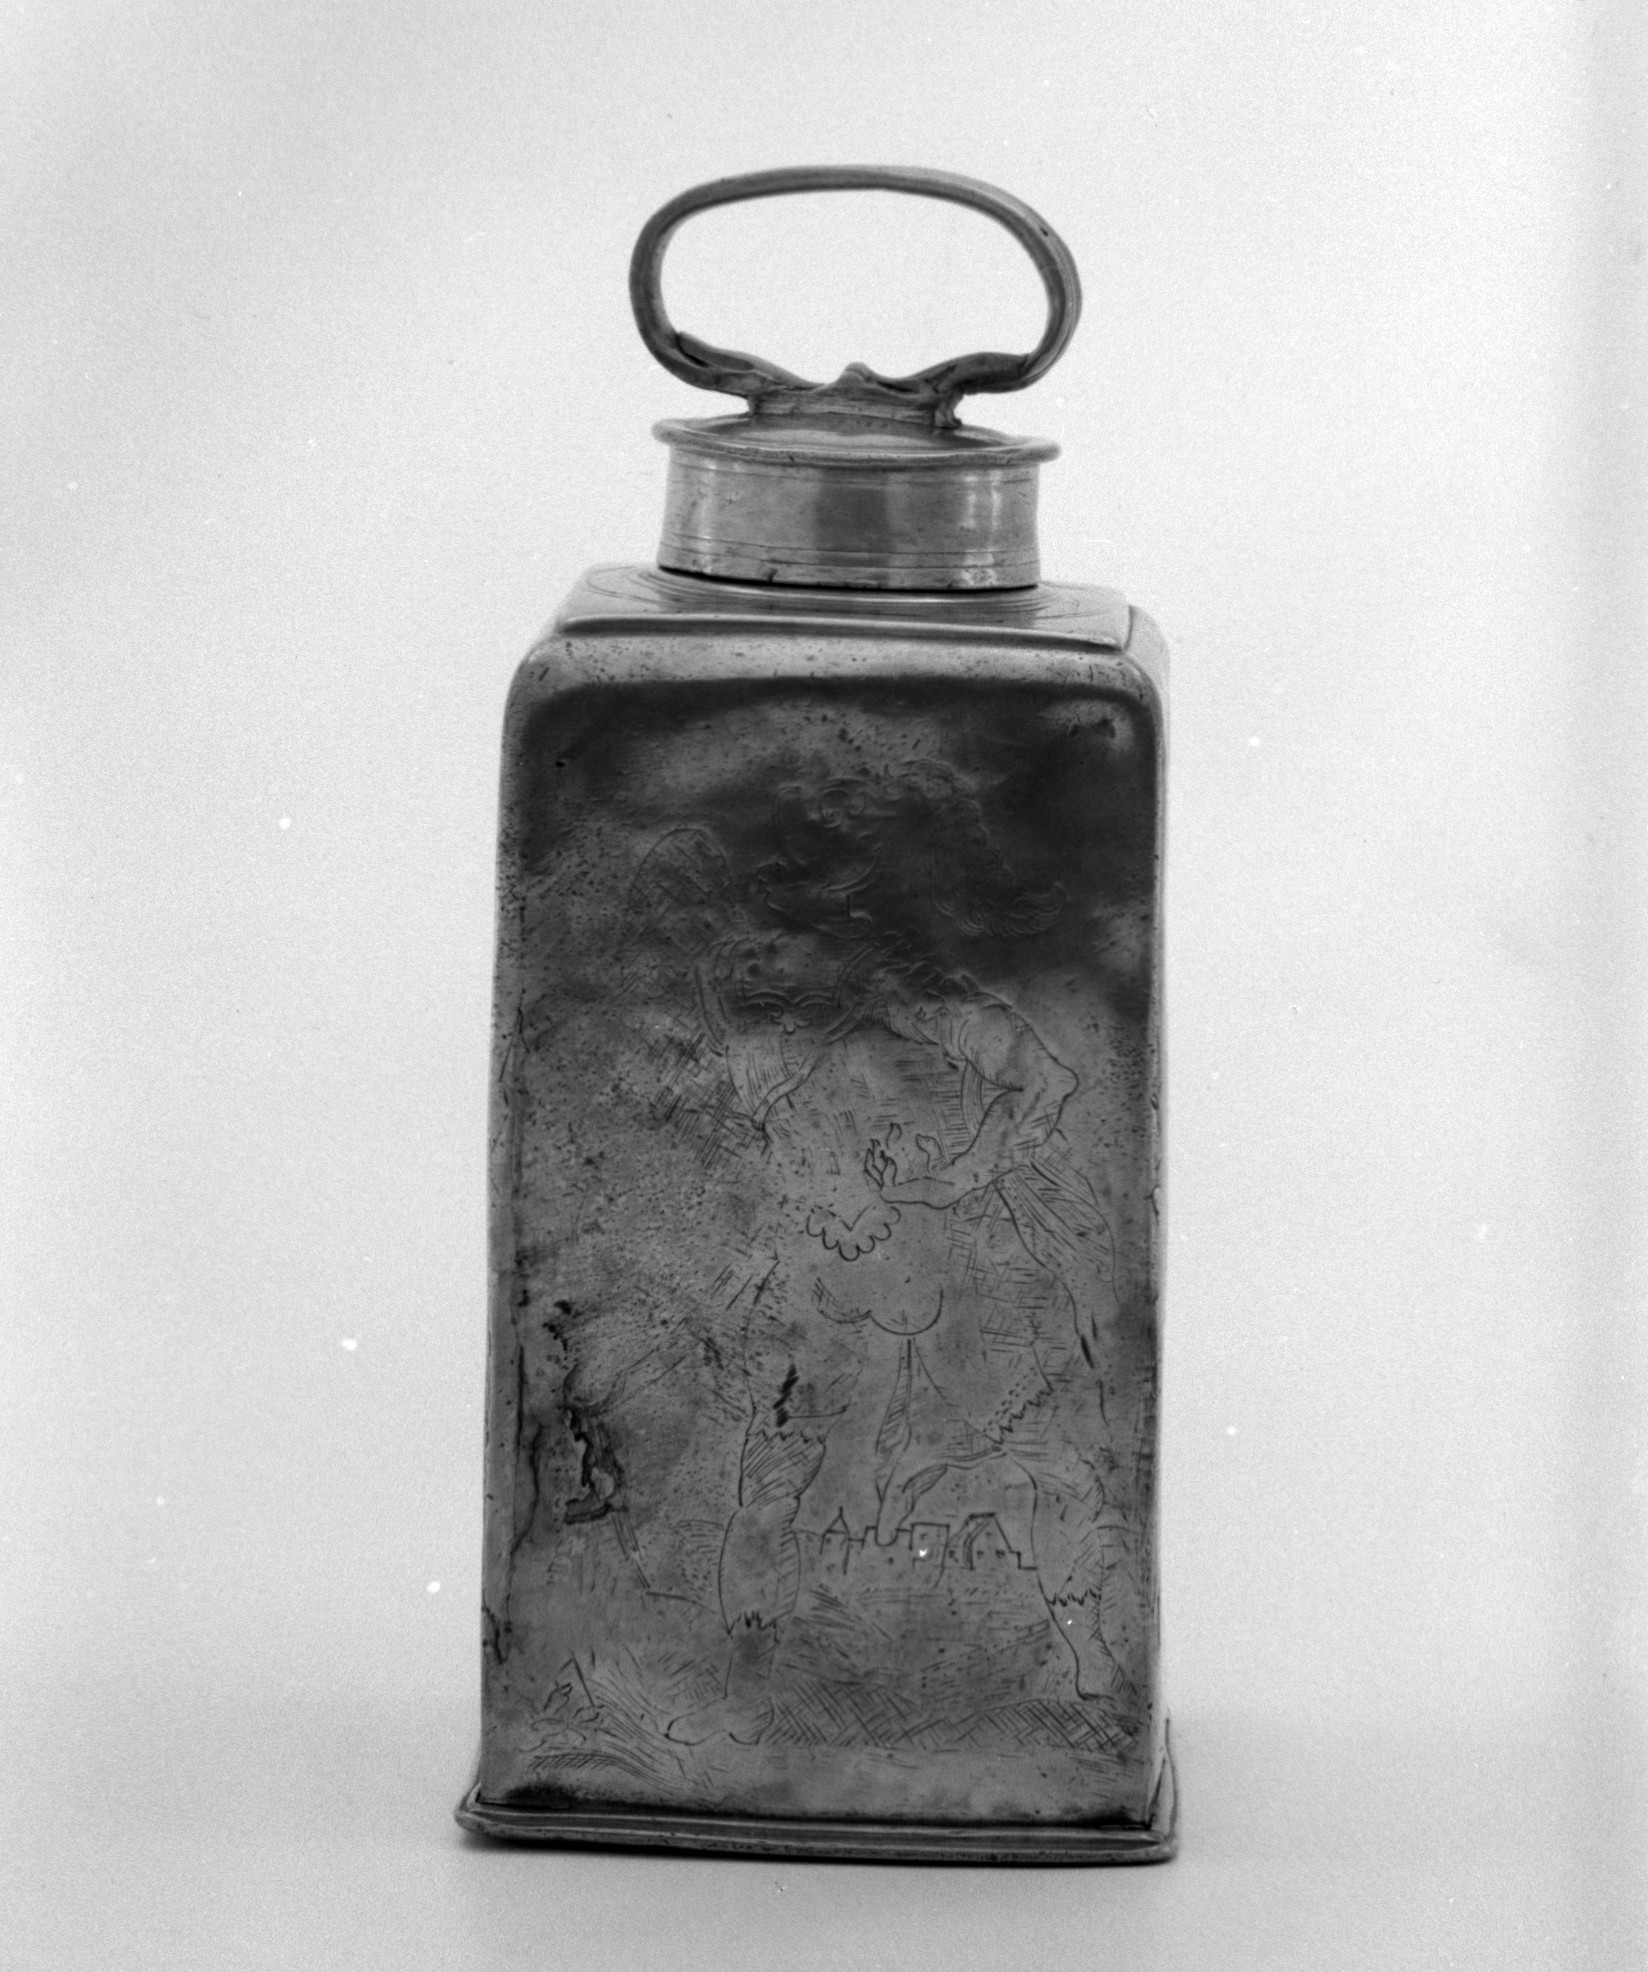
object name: wine jug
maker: christopher lehrl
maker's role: maker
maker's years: 1575-1675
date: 1633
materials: pewter